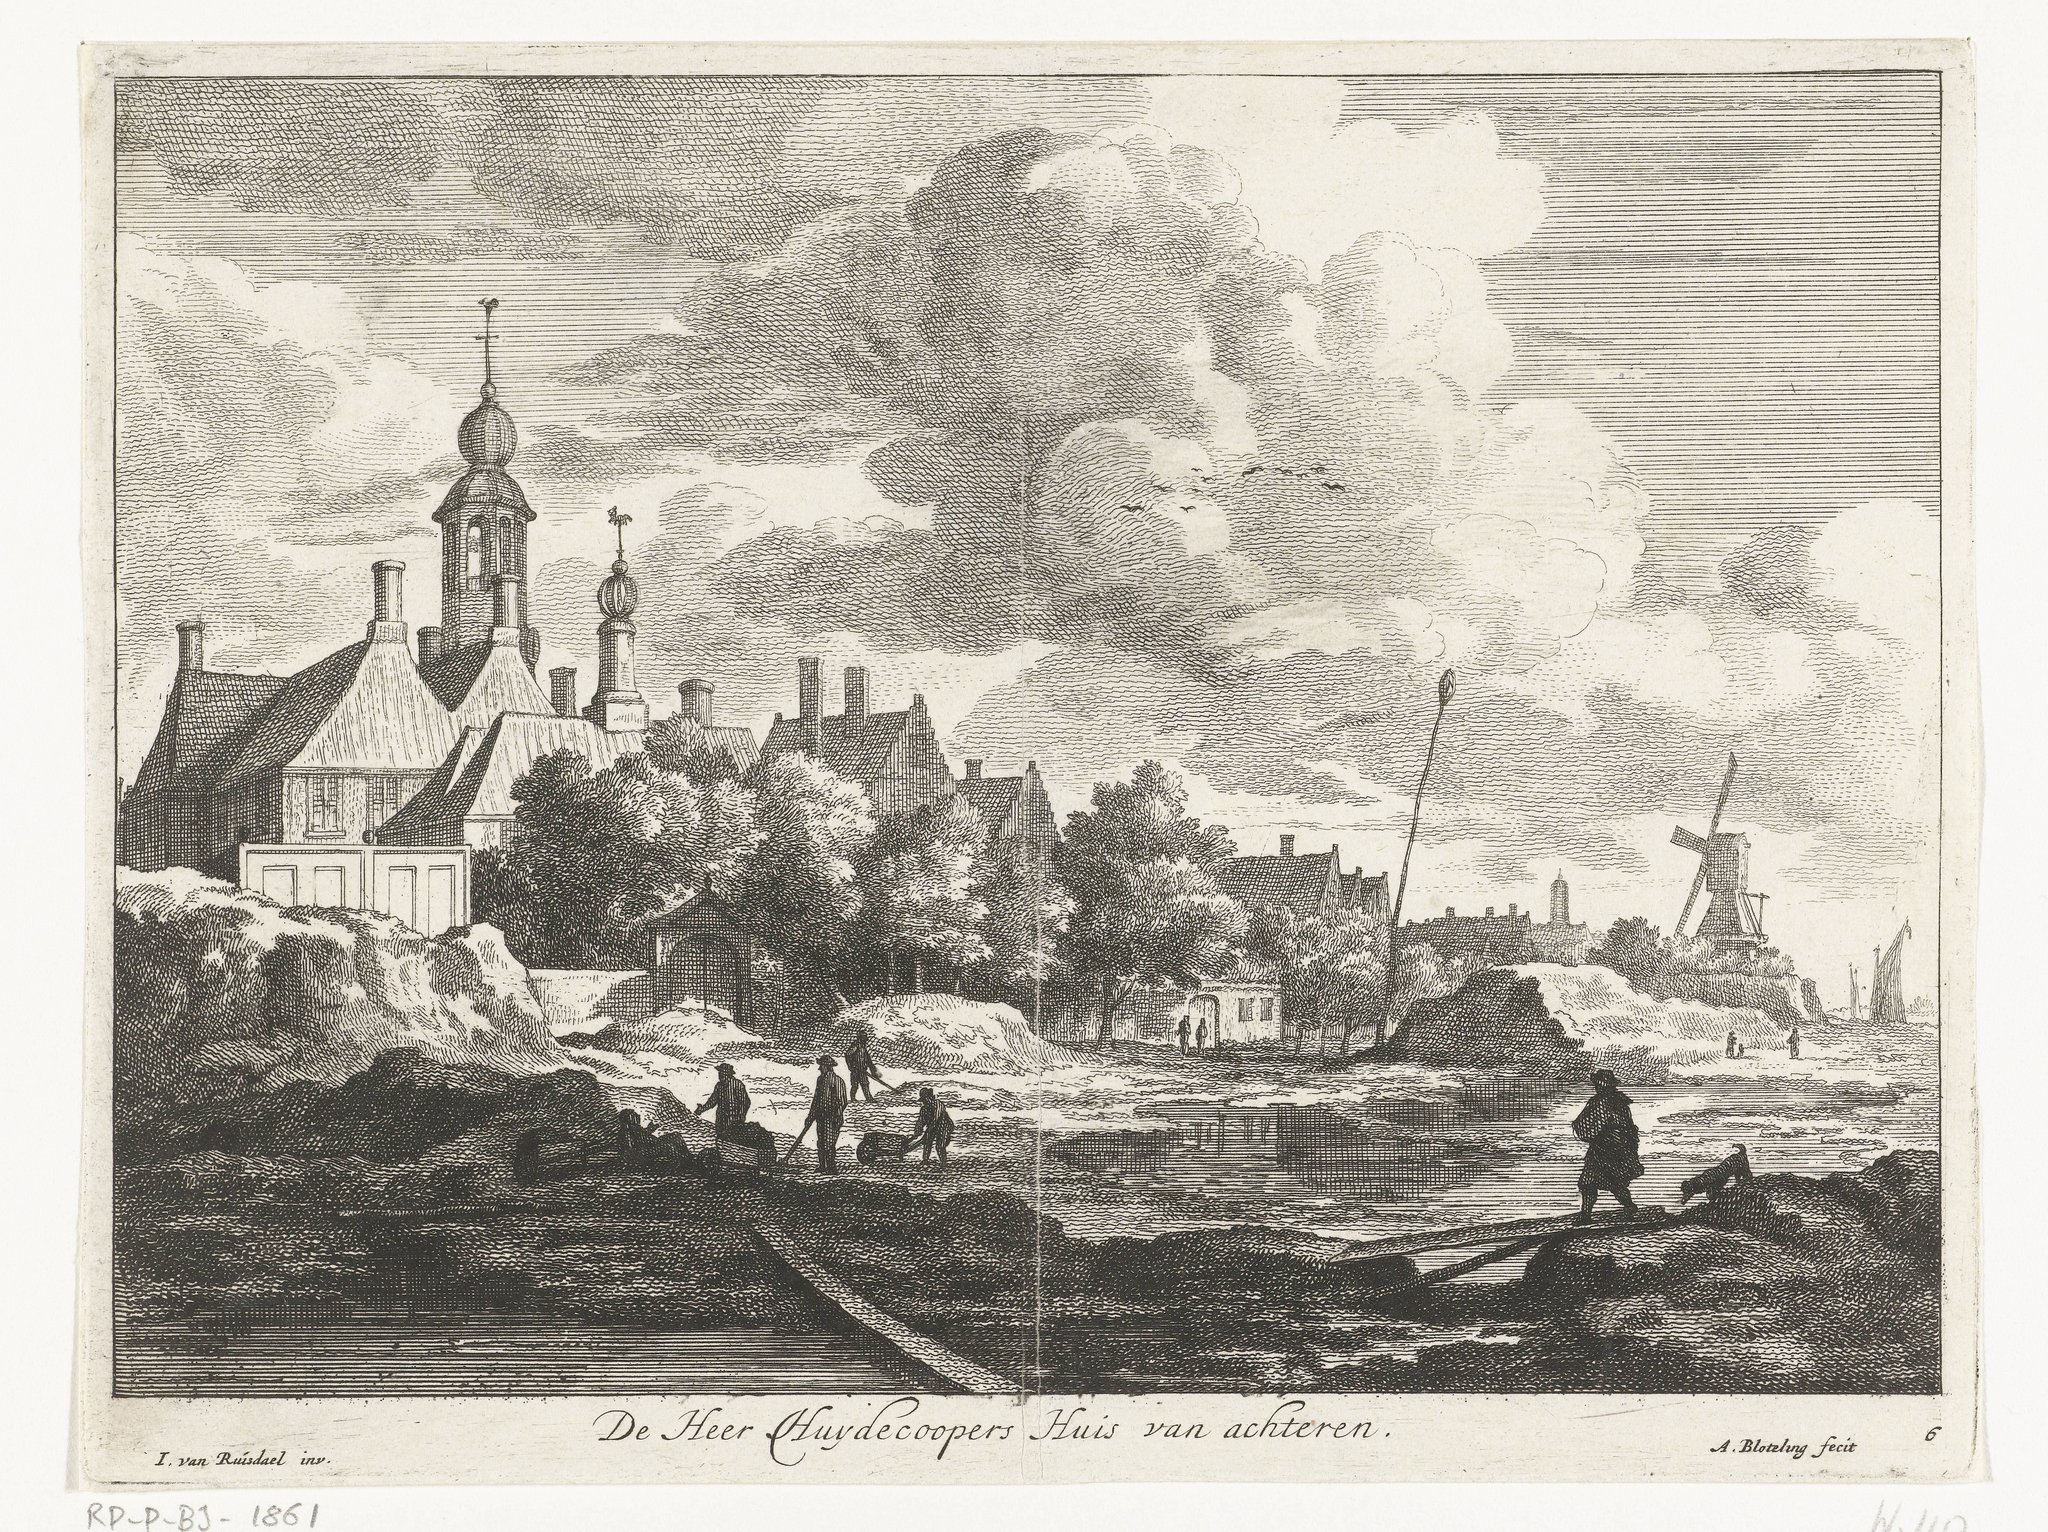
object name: print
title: Gezicht op het huis van de heer Huydecoper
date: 1655-1690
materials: paper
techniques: etching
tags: amsterdam, mayor, joan huydecoper van maarseveen (i)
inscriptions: collector's mark: Lugt 240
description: Gezicht op de achterzijde van het huis van de burgermeester Joan Huydecoper van Maarsseveen. Op de voorgrond zijn arbeiders bezig met het graven van de Herengracht.